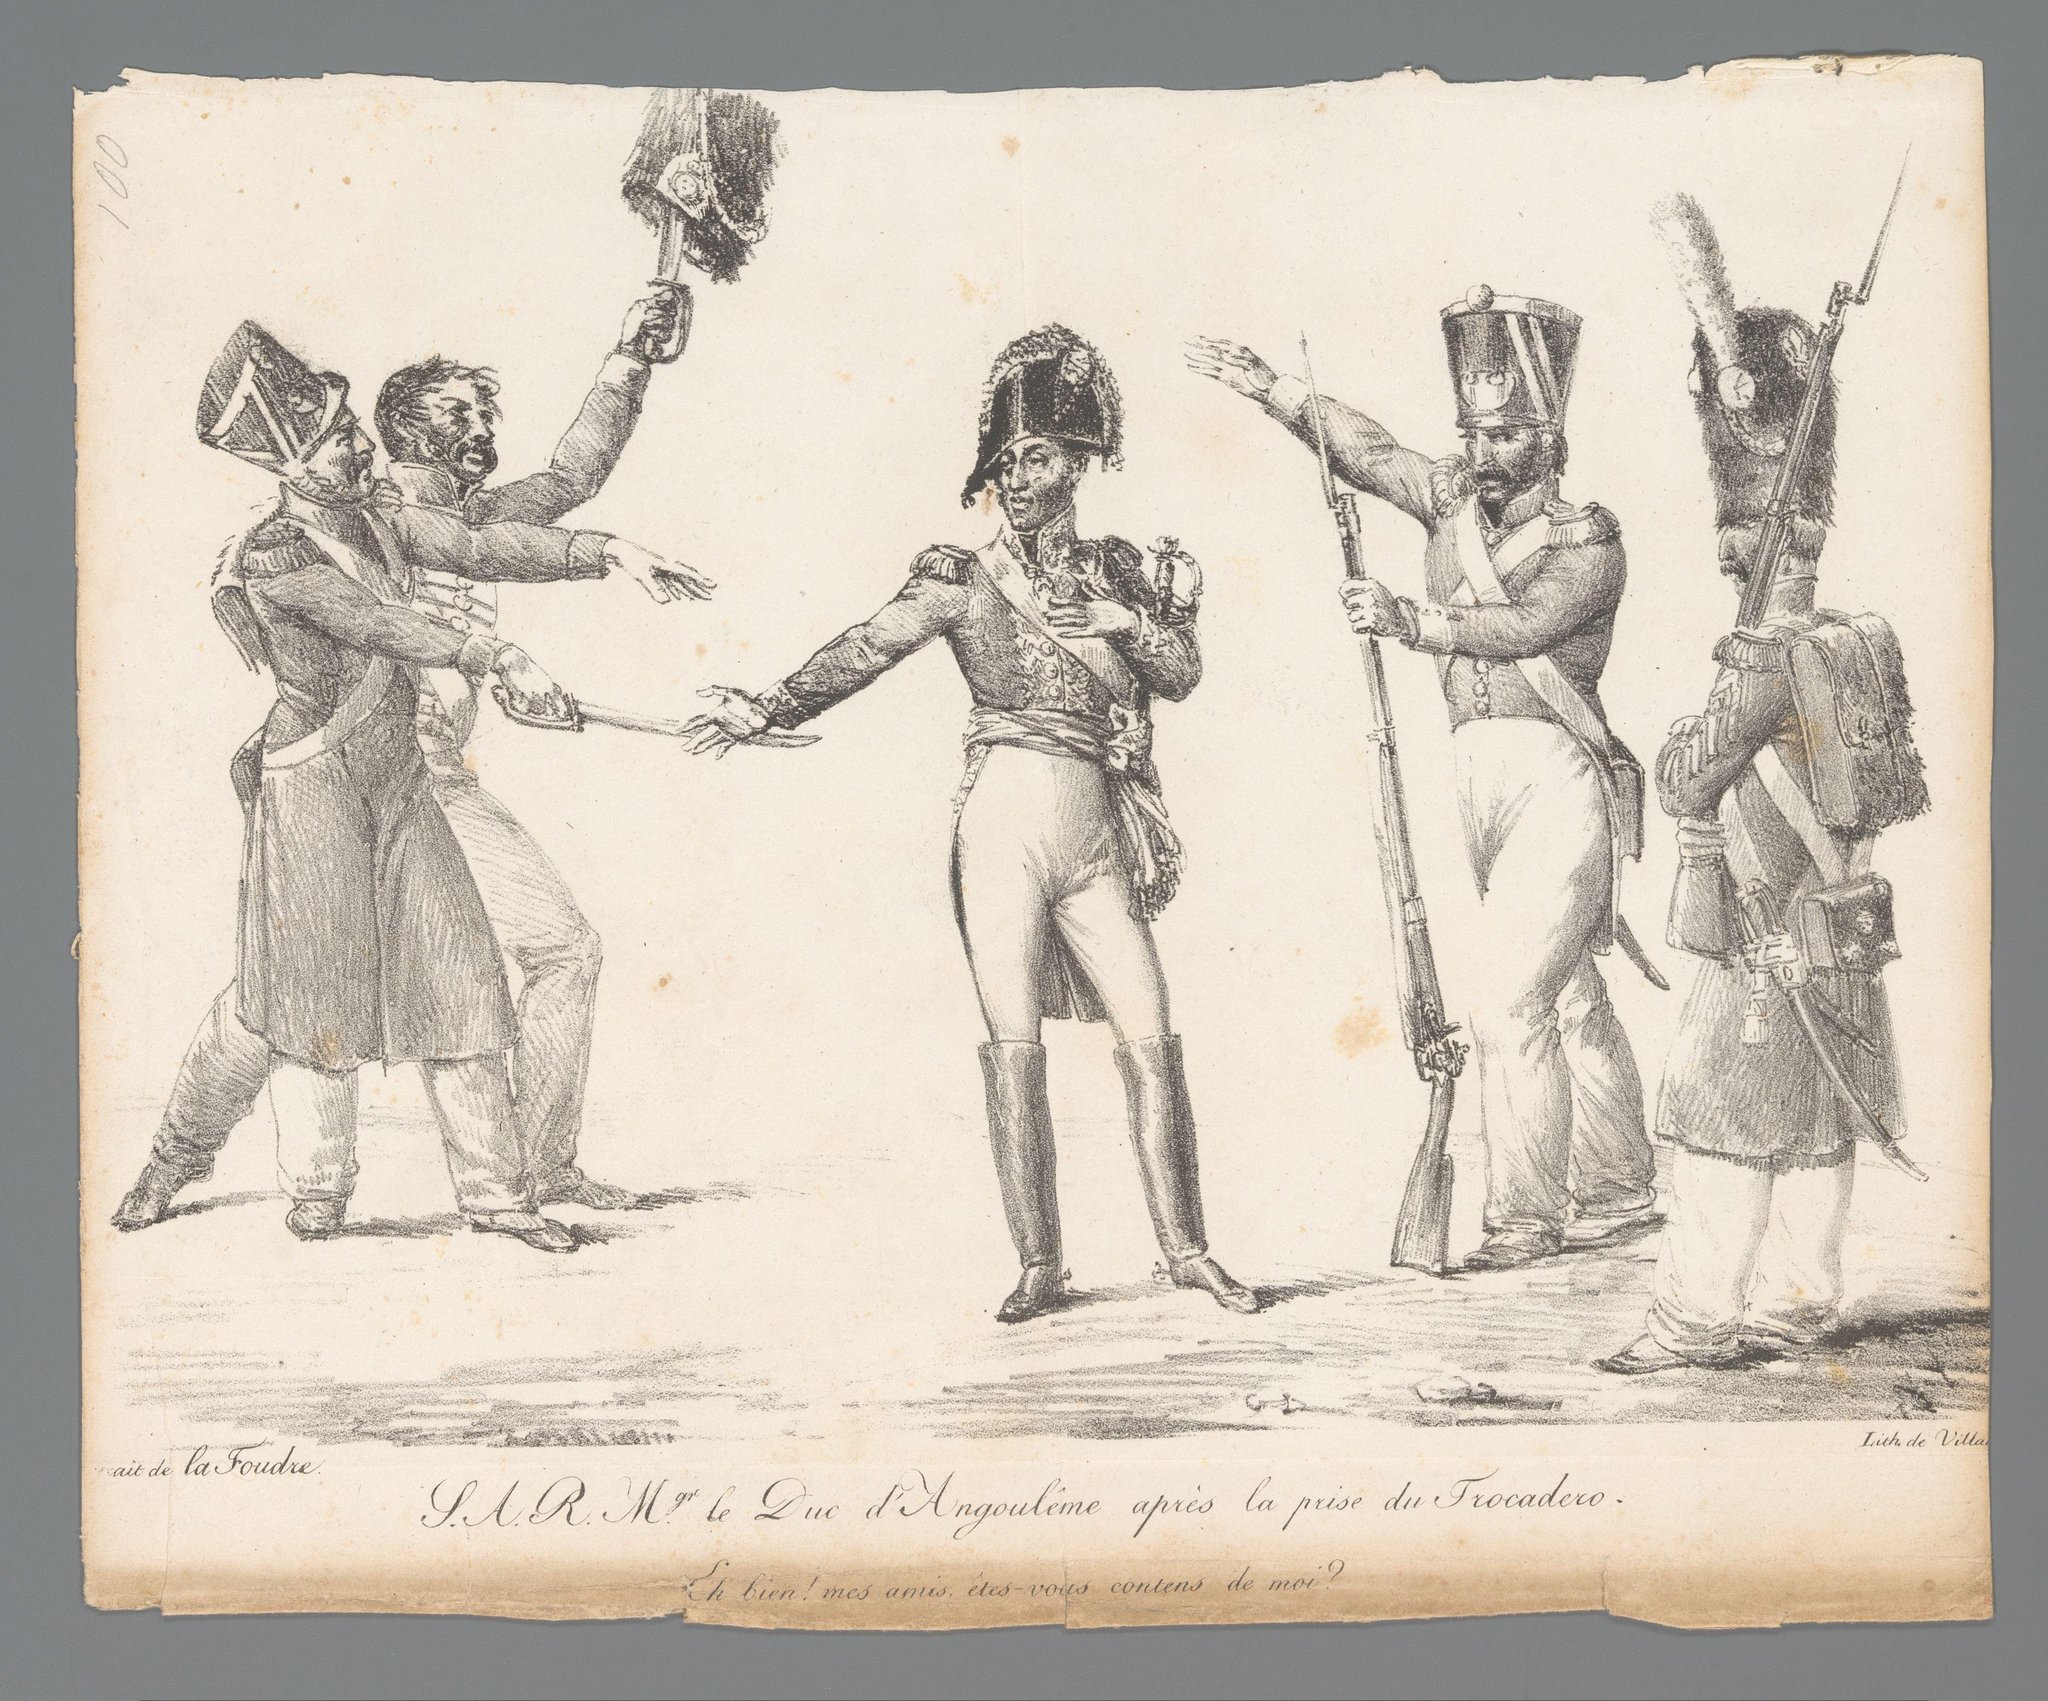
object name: print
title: S.A.R. Mgr. le duc d'Angoulême après la prise du Trocadero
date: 1821-1823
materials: paper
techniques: lithograph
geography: paris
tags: military honours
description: Prent uit: Le Foudre, journal de la littérature, des spectacles et des arts, 1821-1823.